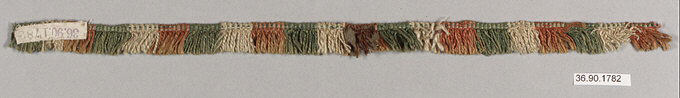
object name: fringe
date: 1867-1900